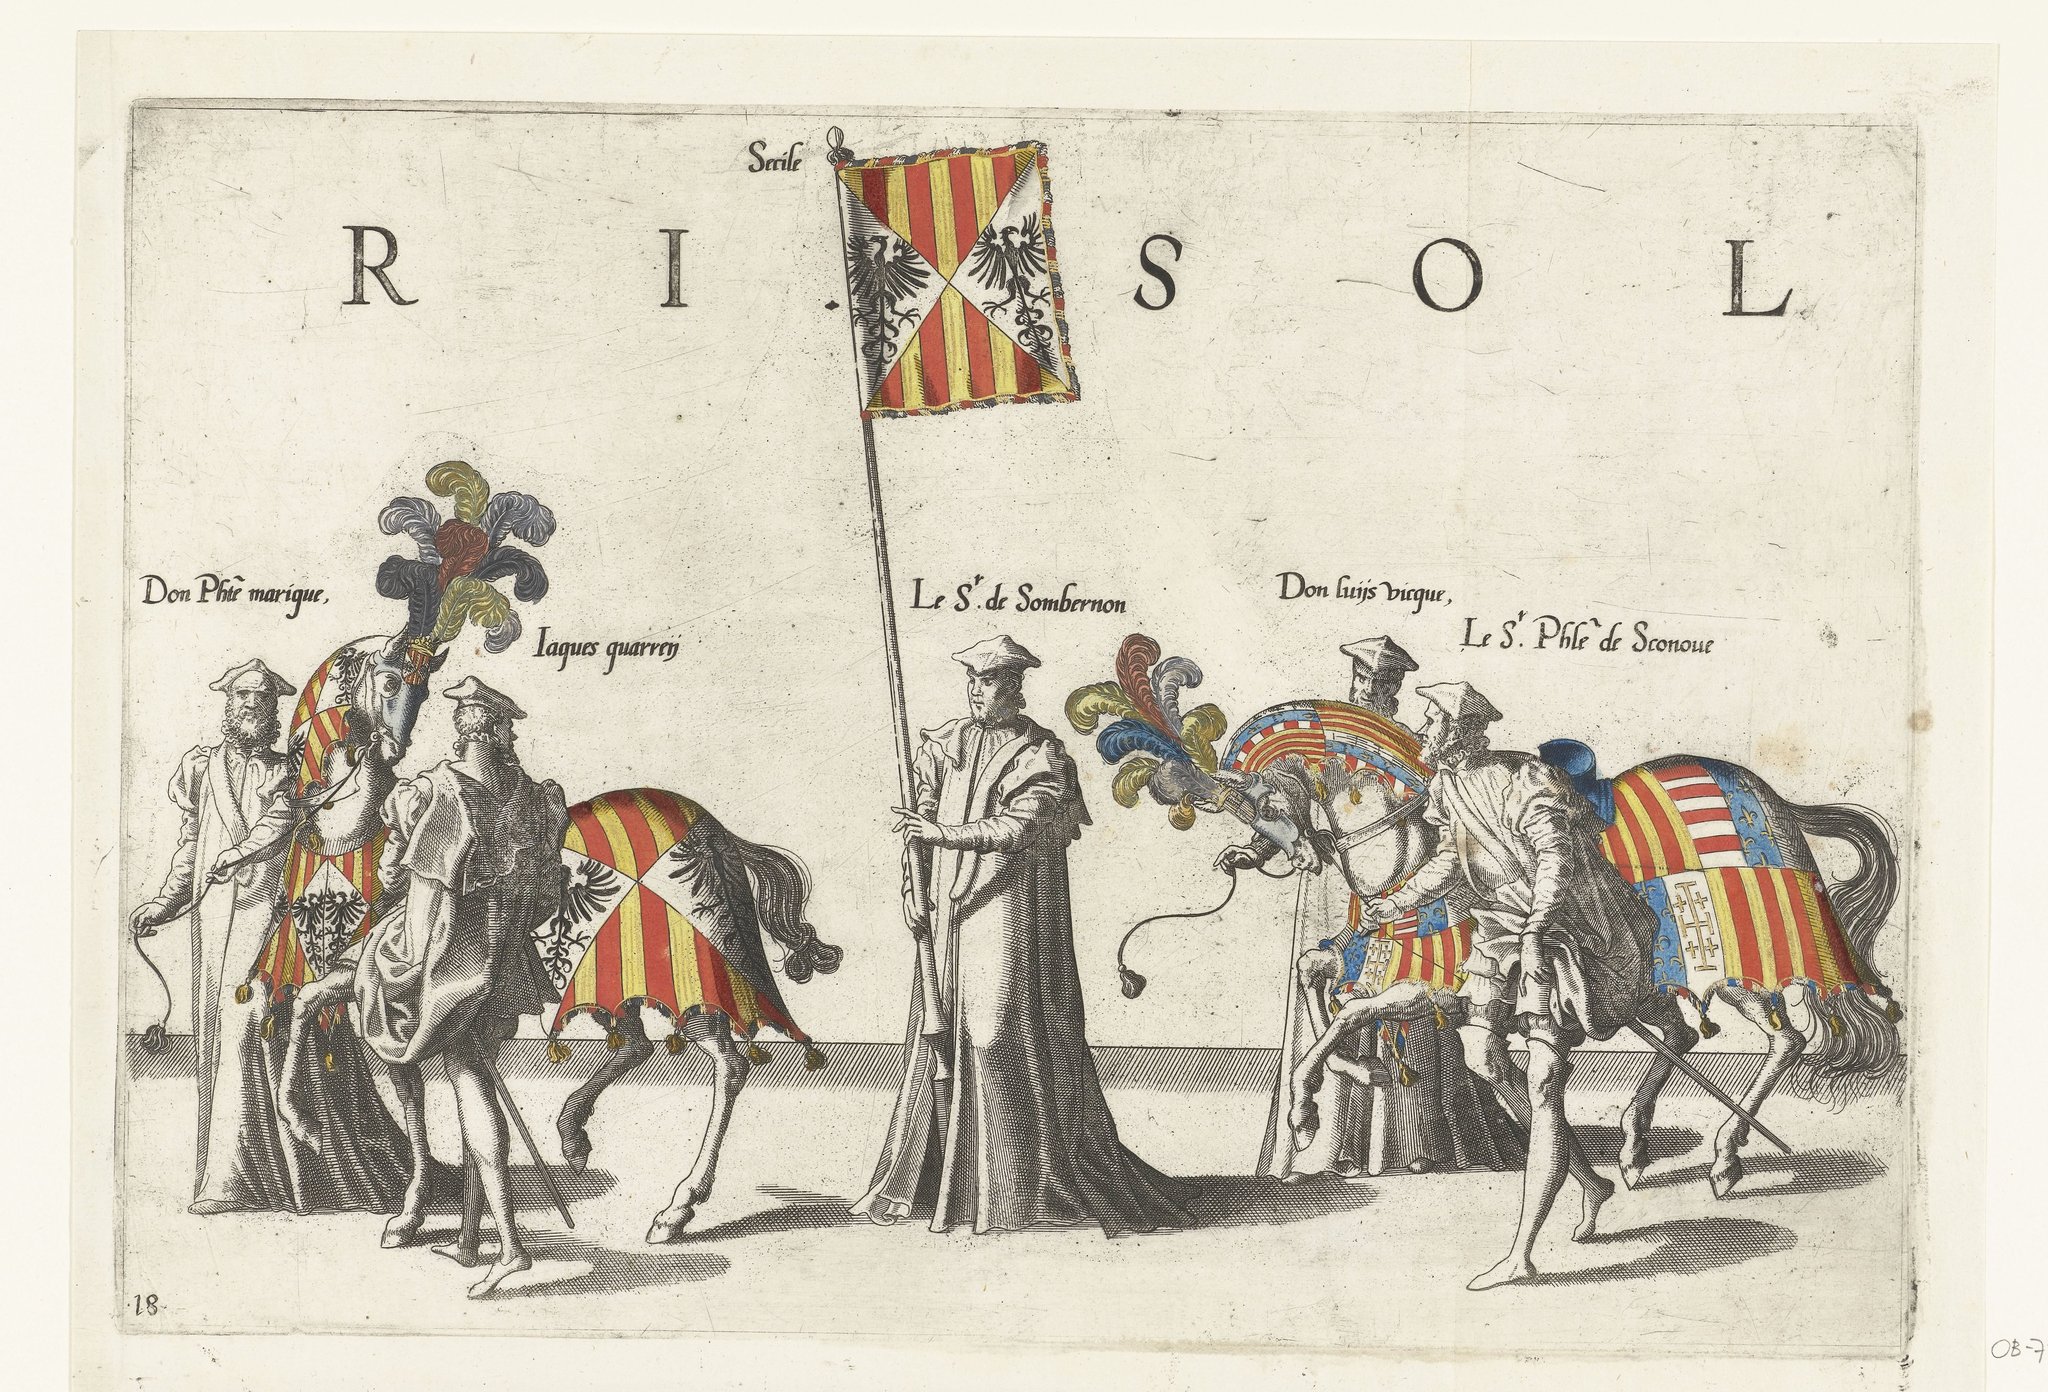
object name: print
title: Begrafenisoptocht van keizer Karel V, 1558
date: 1559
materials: paper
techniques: engraving, etching, hand coloring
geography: southern netherlands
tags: ghent, charles v (holy roman emperor and king of spain), cortege, funeral procession, brussels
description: Vier deelnemers aan de optocht, paarden en de vaandels met de wapens van Navarra en Jeruzalem. Onderdeel van de prentreeks van de Begrafenisoptocht van keizer Karel V op 29 december 1558 te Brussel.